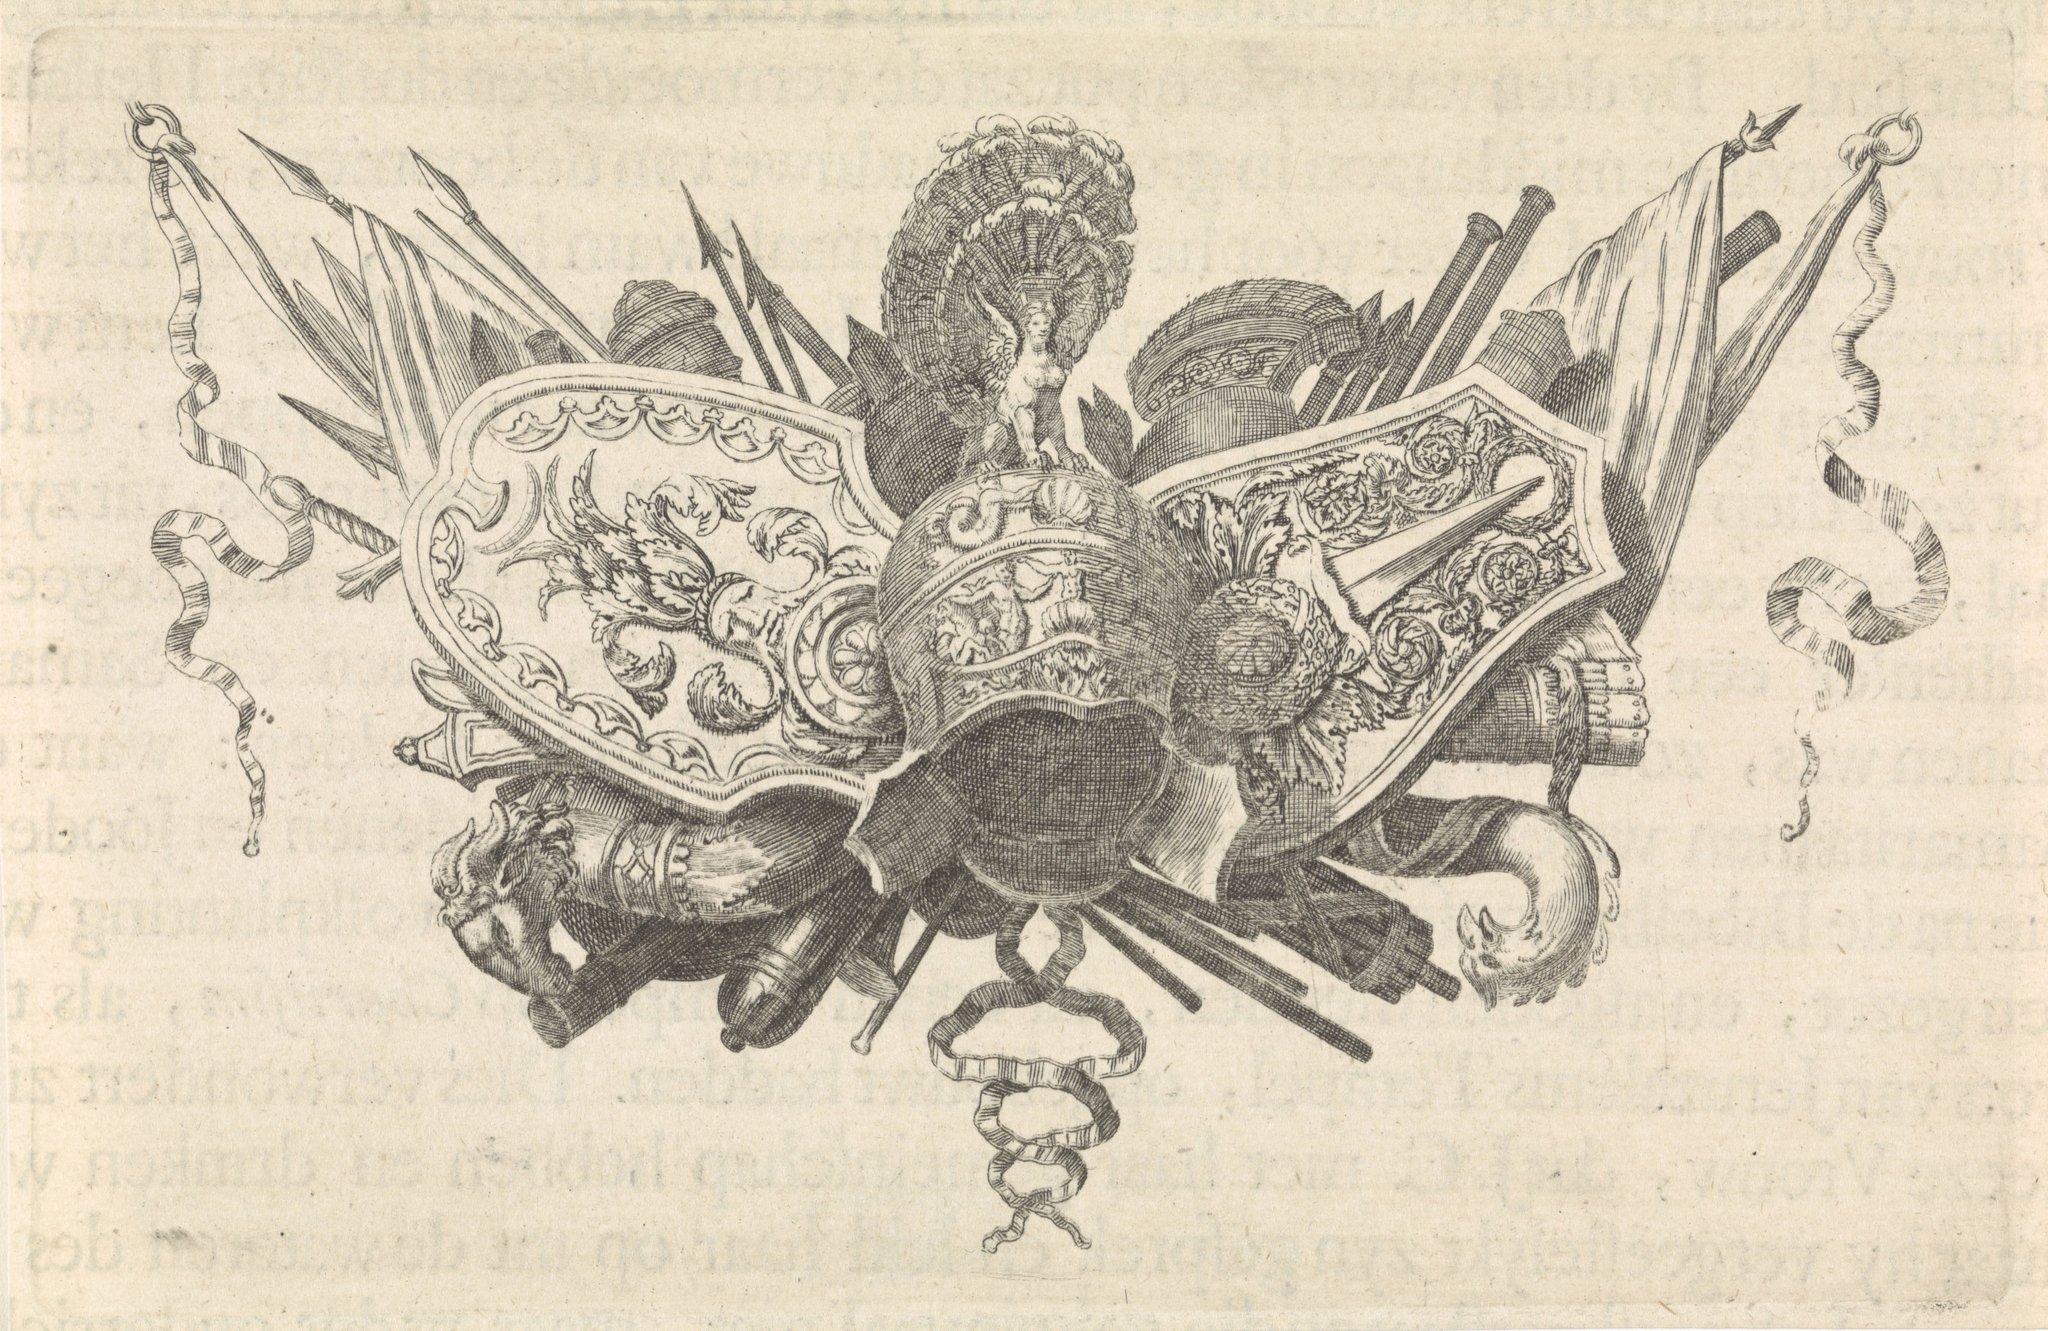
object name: ornament print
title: Vignet met een trofee van een wapenuitrusting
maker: bernard picart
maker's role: draughtsman, print maker, publisher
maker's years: 1673-1733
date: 1683-1733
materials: paper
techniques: engraving, etching, letterpress printing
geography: amsterdam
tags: trophy, i.e.: decorative arrangement of symbolic or typical objects ~ ornament, 'tropaion', i.e. decorative ornament ~ weapons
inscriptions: collector's mark: Lugt 2228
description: Prent oorspronkelijk bedoeld voor: Figures de la Bible. Amsterdam, Bernard Picart, 1720. Prent ook gebruikt in: Taferelen der voornaamste geschiedenissen van het Oude en Nieuwe Testament (...) door de vermaarde kunstenaars Hoet, Houbraken, en Picart getekent (...) en met beschrijvingen uitgebreid. Den Haag: Pieter de Hondt, 1728. Prent kan mogelijk ook zijn gebruikt in andere bijbels.